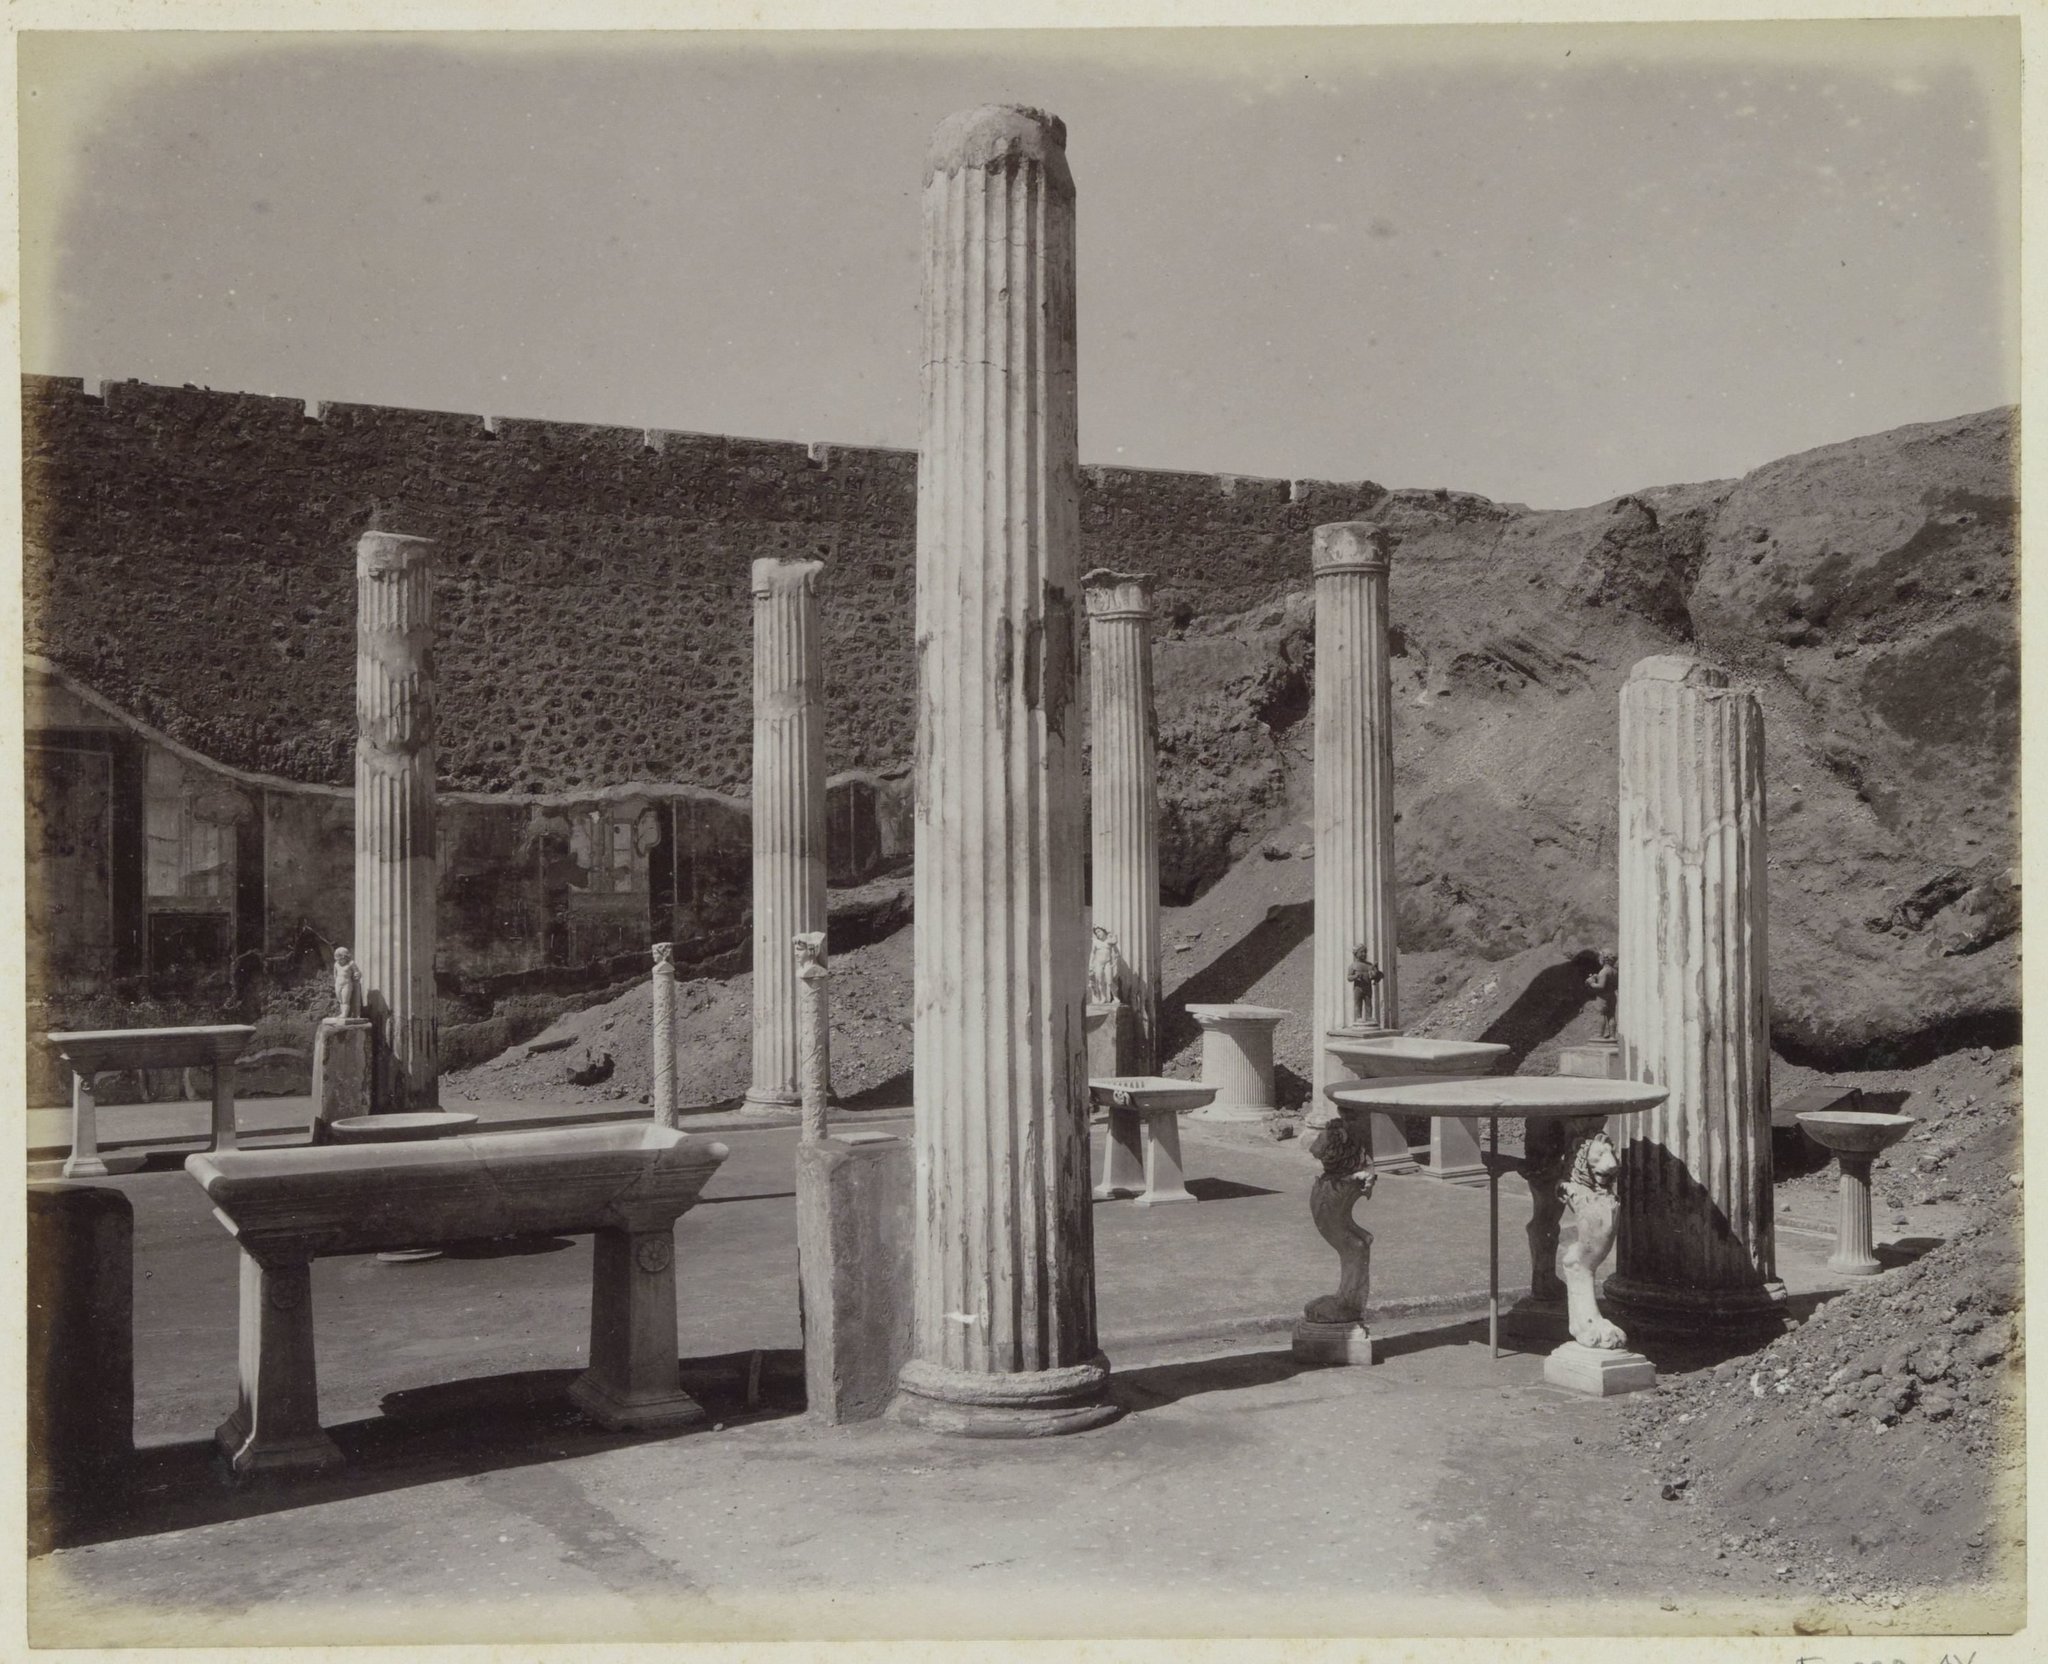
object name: photograph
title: Zuilen en sculpturen bij een muur in Pompeï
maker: giorgio sommer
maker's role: fotograaf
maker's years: 1834-1914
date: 1870-1900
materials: paper, photographic support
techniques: albumen print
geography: pompeii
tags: piece of sculpture, reproduction of a piece of sculpture (+ sculpture), column, pillar ~ architecture, excavation ~ archaeology, pompeii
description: Onderdeel van Reisalbum met foto's van bezienswaardigheden in Italië en Frankrijk.